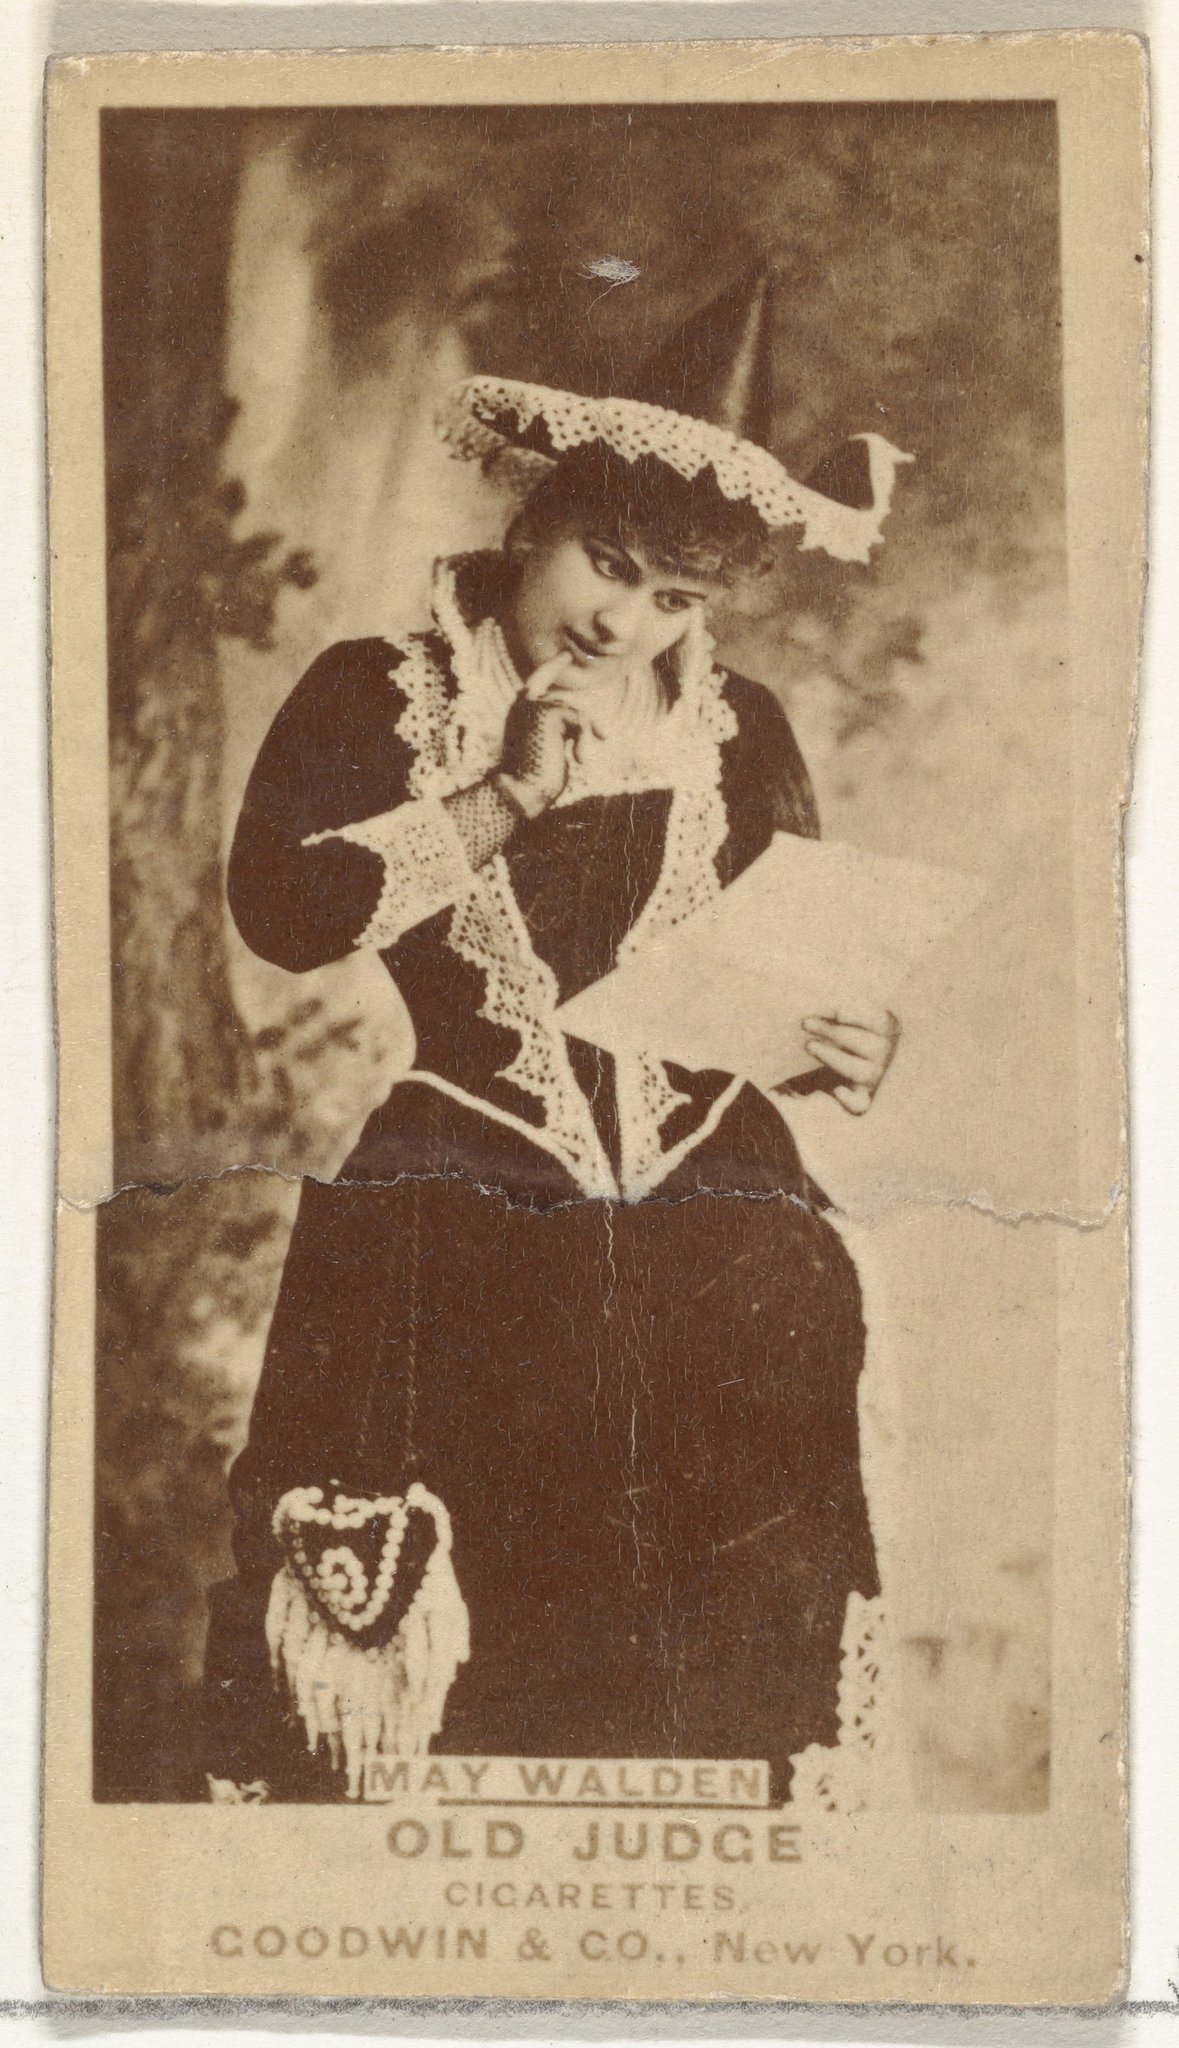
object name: photograph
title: May Walden, from the Actors and Actresses series (N171) for Old Judge Cigarettes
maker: goodwin & company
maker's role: publisher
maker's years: 1850-1950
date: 1886-1890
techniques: albumen silver print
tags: portraits,women,reading,actresses